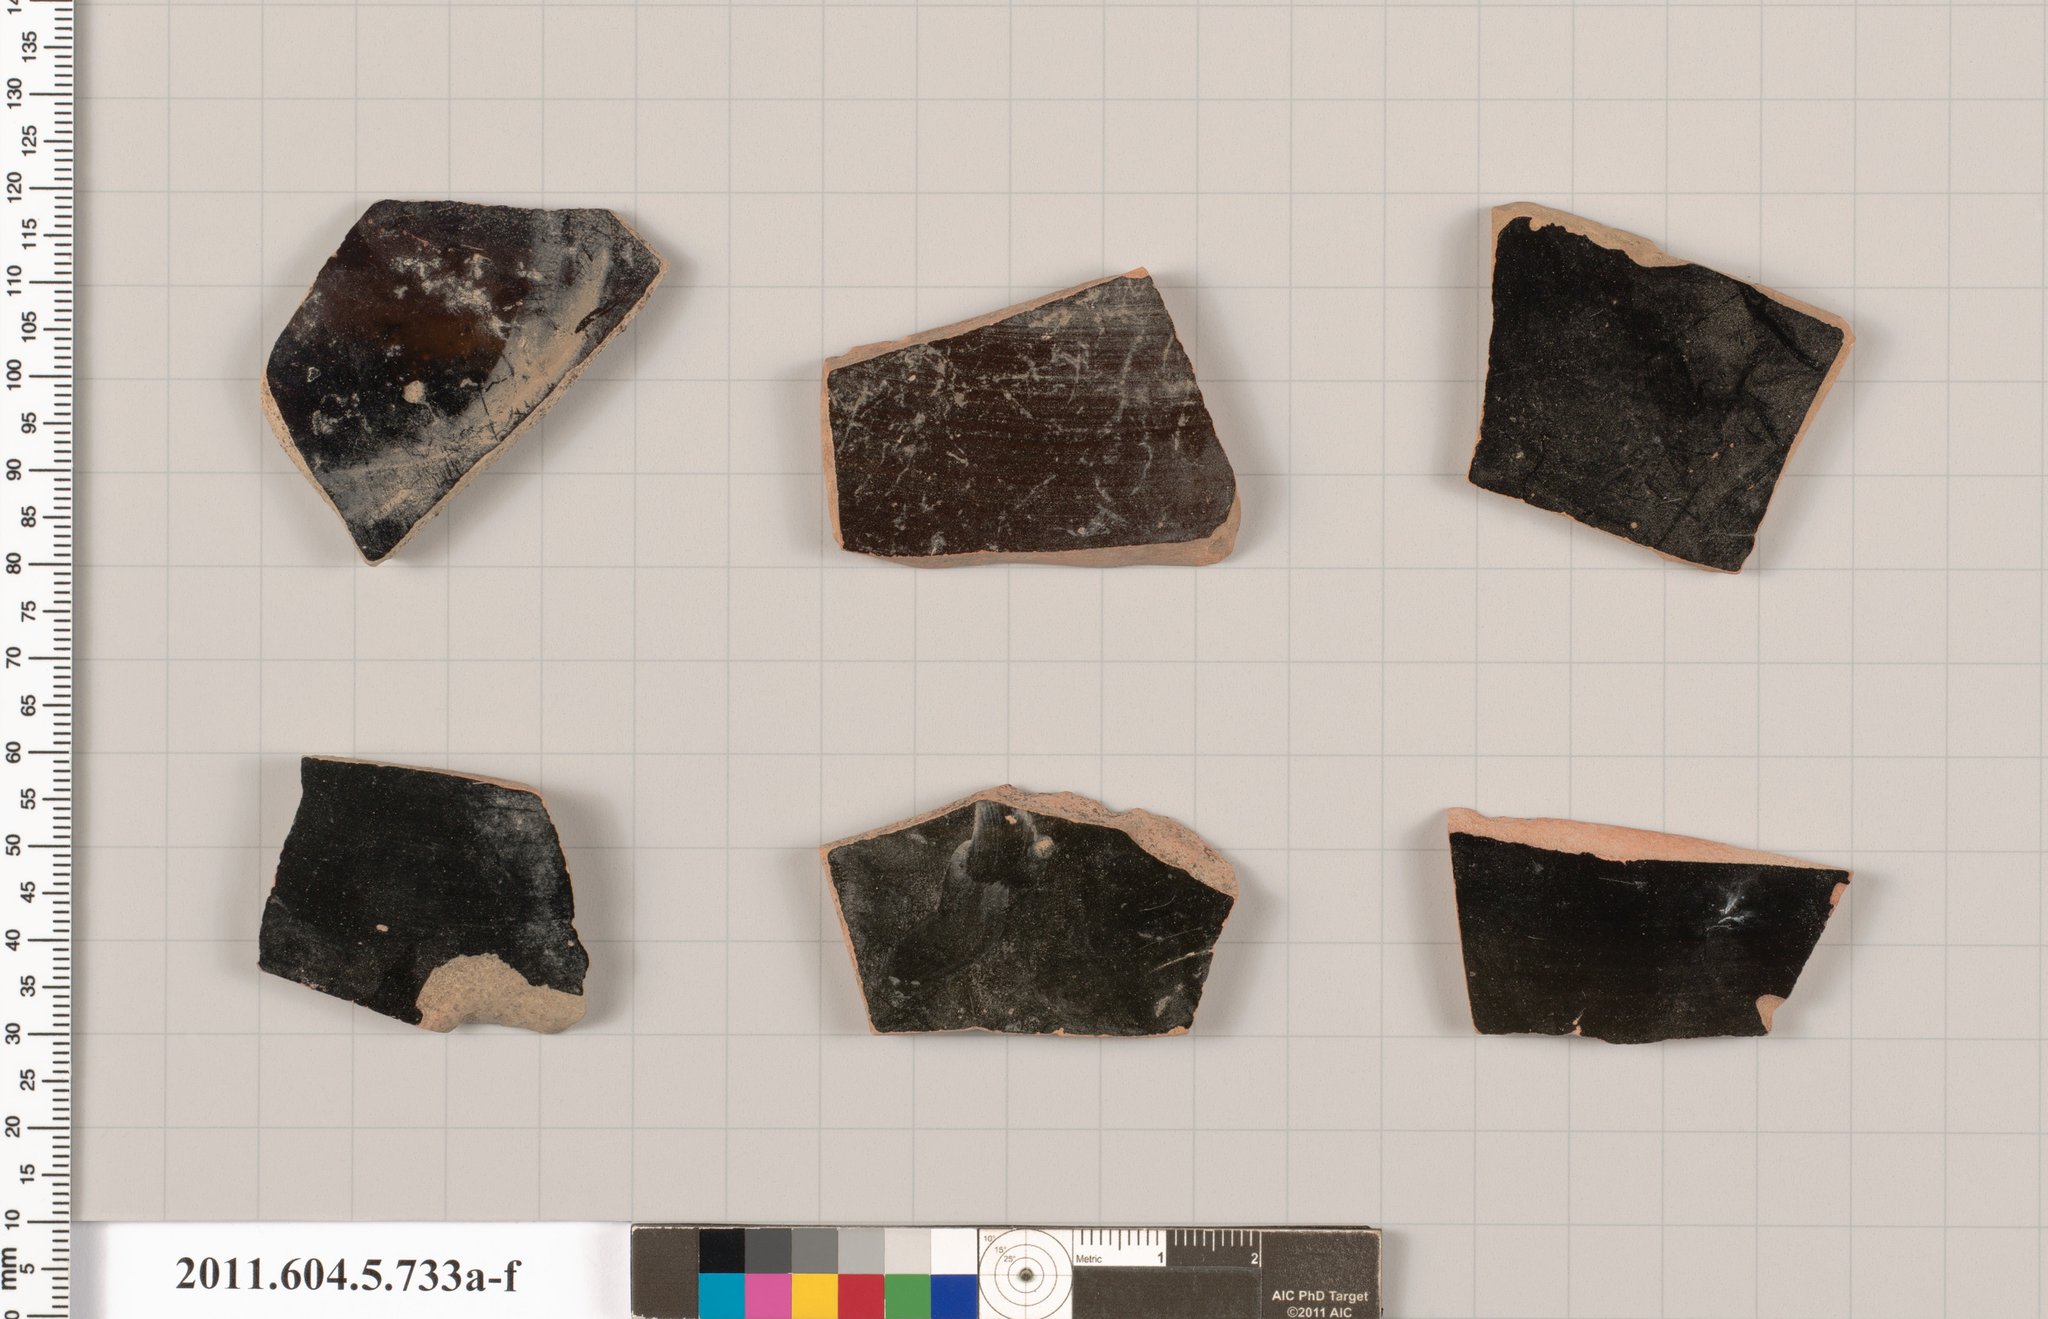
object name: kylix fragment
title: Terracotta fragments of kylikes (drinking cups)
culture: greek, attic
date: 600-401 BCE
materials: terracotta